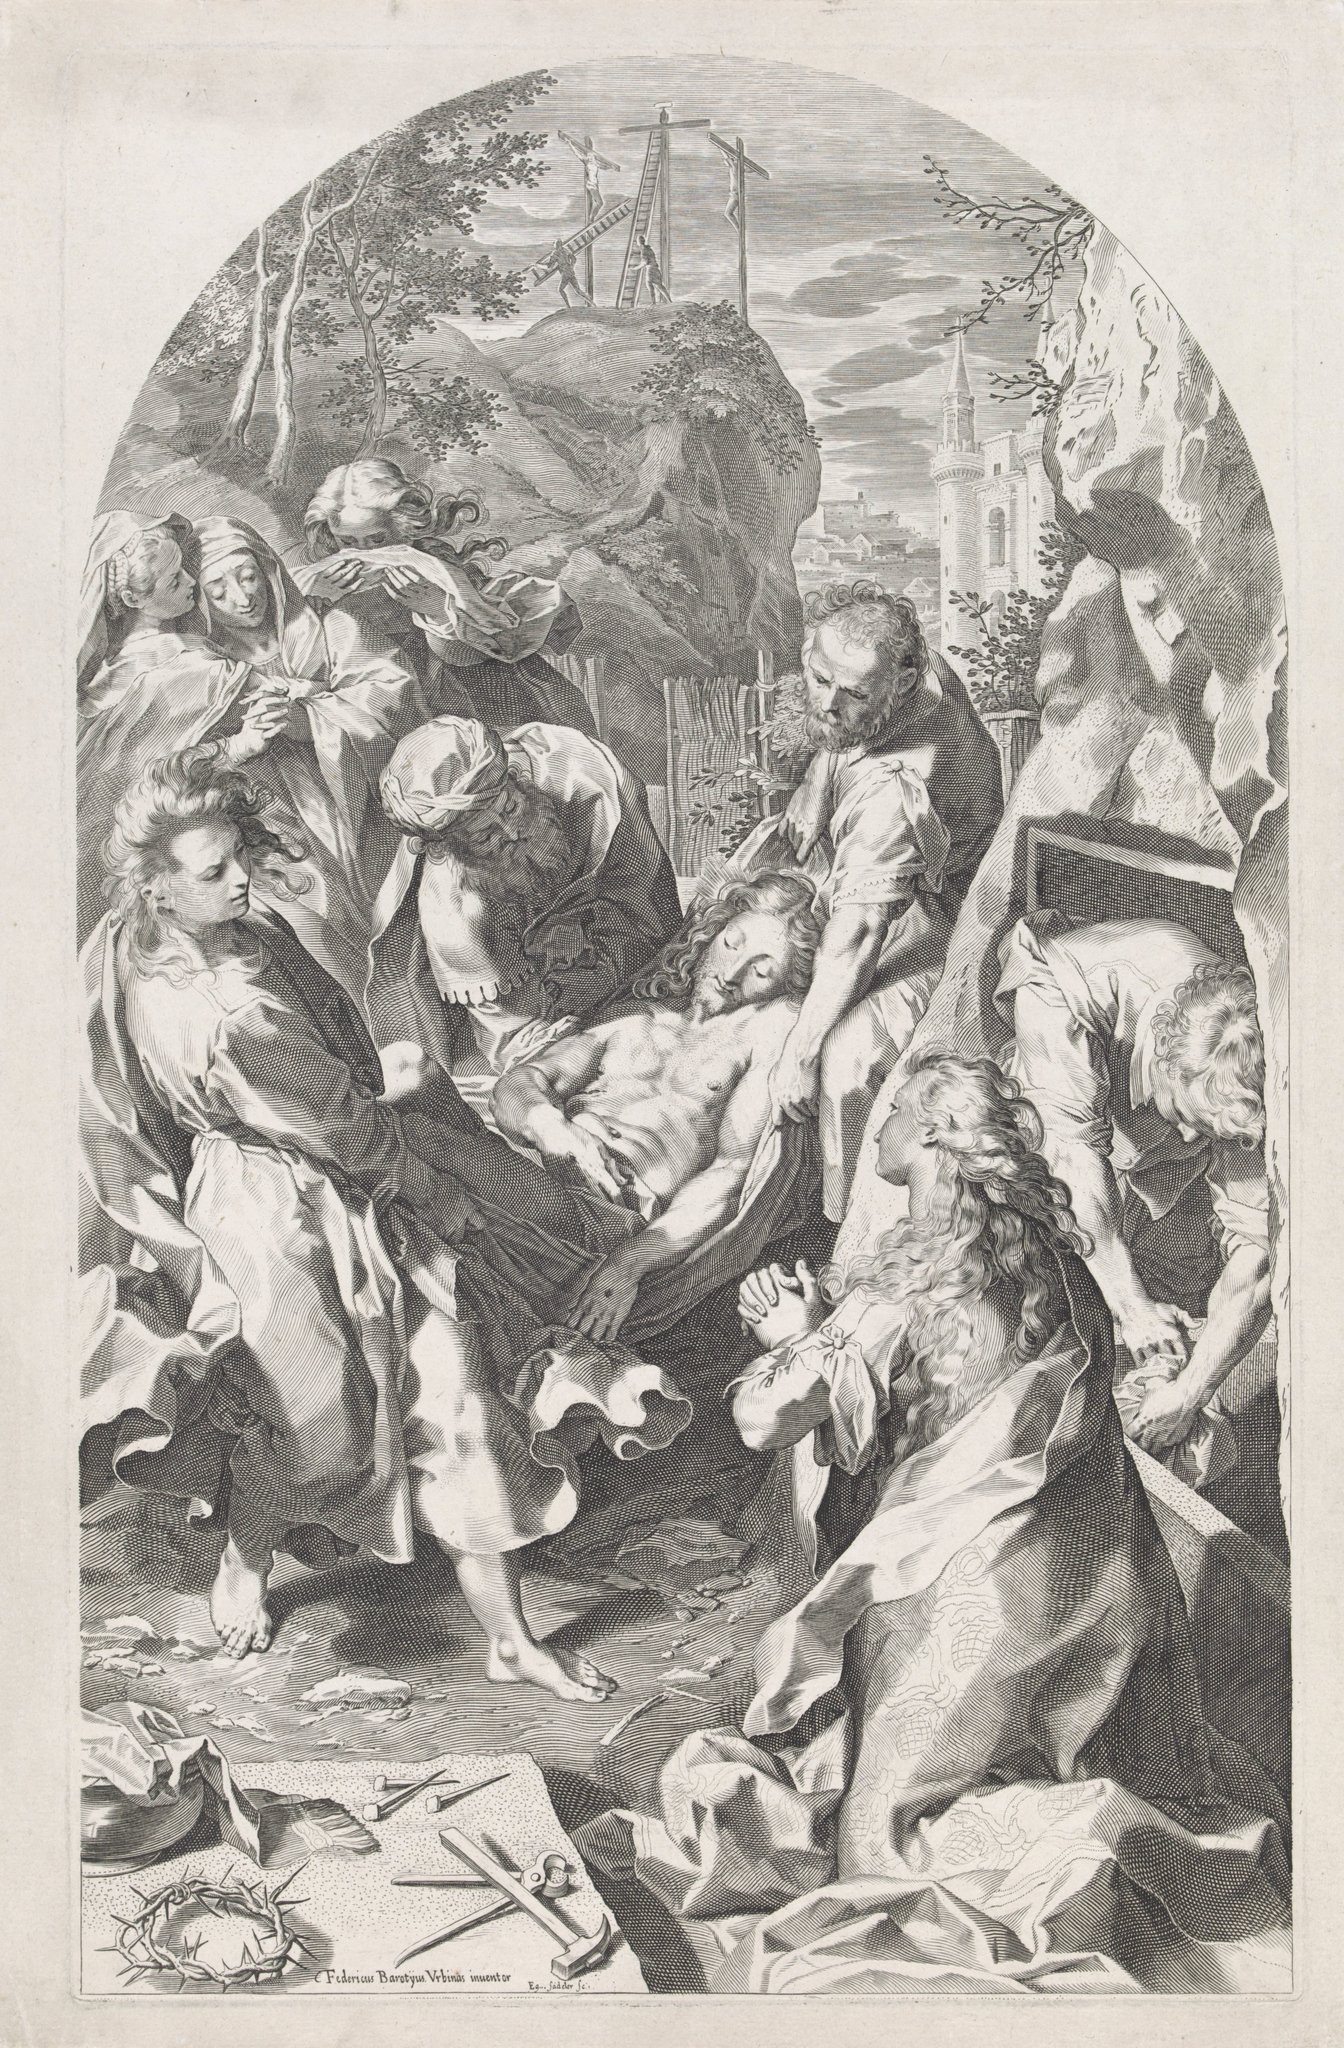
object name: print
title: Graflegging van Christus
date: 1591-1615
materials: paper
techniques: engraving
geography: italy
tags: christ's entombment (possibly by angels)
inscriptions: collector's mark: Lugt 2760, collector's mark: Lugt 2228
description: Het lichaam van Christus wordt door drie mannen, onder wie Jozef van Arimatea en Nikodemus, naar zijn geopende graftombe gedragen. Achter hen rouwt Maria samen met twee vrouwen. Vooraan knielt een vrouw met gevouwen handen, Maria Magdalena(?). Links vooraan liggen de martelwerktuigen. In de verte de drie kruisen op een rots.